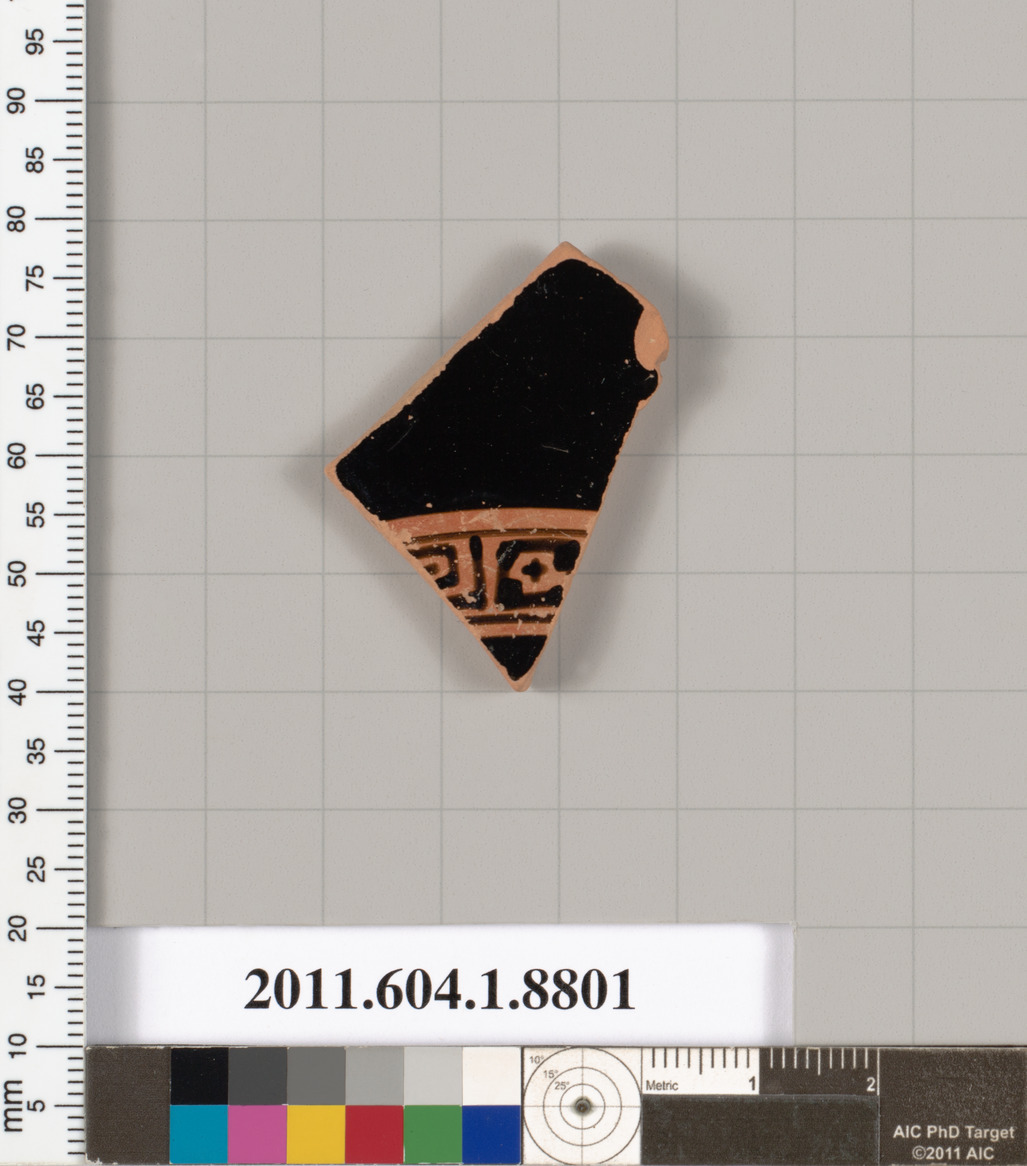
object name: kylix fragment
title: Terracotta fragment of a kylix (drinking cup)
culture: greek, attic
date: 490-480 BCE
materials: terracotta